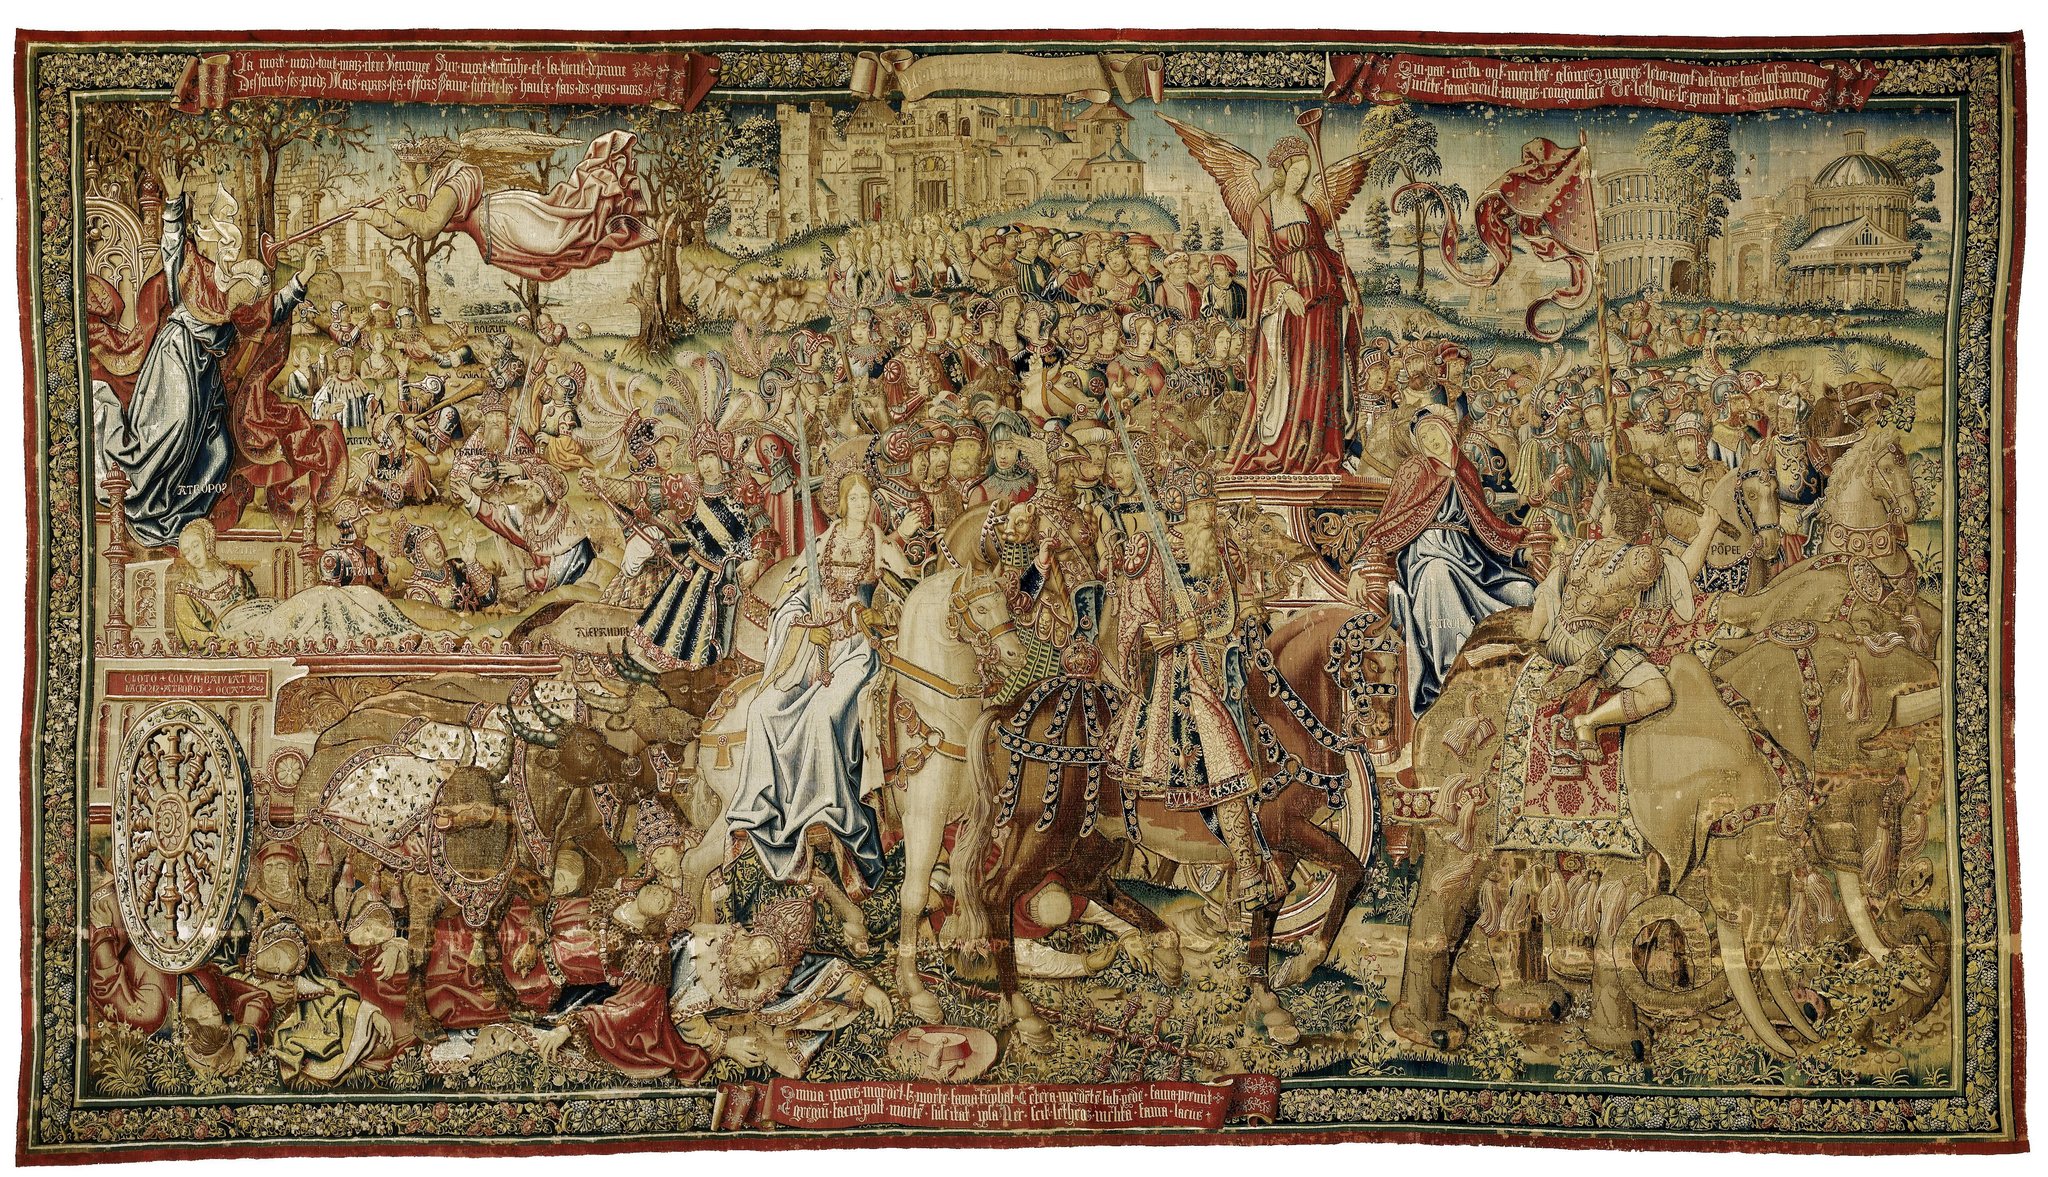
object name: tapestry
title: De triomfen van Petrarca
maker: Anonymous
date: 1510-1525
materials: silk, wool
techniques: tapestry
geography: brussels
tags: personifications of death; 'morte' (ripa) - ff - death as female, atropos, usually with shears, 'trionfo della fama', 'triumphus famae'; 'carro della fama' (ripa)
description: Tapestry. The Triumph of Fame over Death. Wool, silk. Brussels, c. 1515 - 1525. This tapestry is one of a set of six made after a poem of 1354 by Petrarch, entitled I Trionfi, which describes six allegorical triumphs. On the left of the tapestry Death is conquered by Fame. Death stands on a triumphal car, but is pushed off it by Fame, who comes flying in from the right. Death is symbolized by Atropos, the goddess who cuts the thread of life. On the right Fame stands victorious on a triumphal car with Atropos at her feet. Round the triumphal car appears a procession of famous men: statesmen, artists, scholars. All of them have conquered death and risen from their graves to join the triumph of Fame.